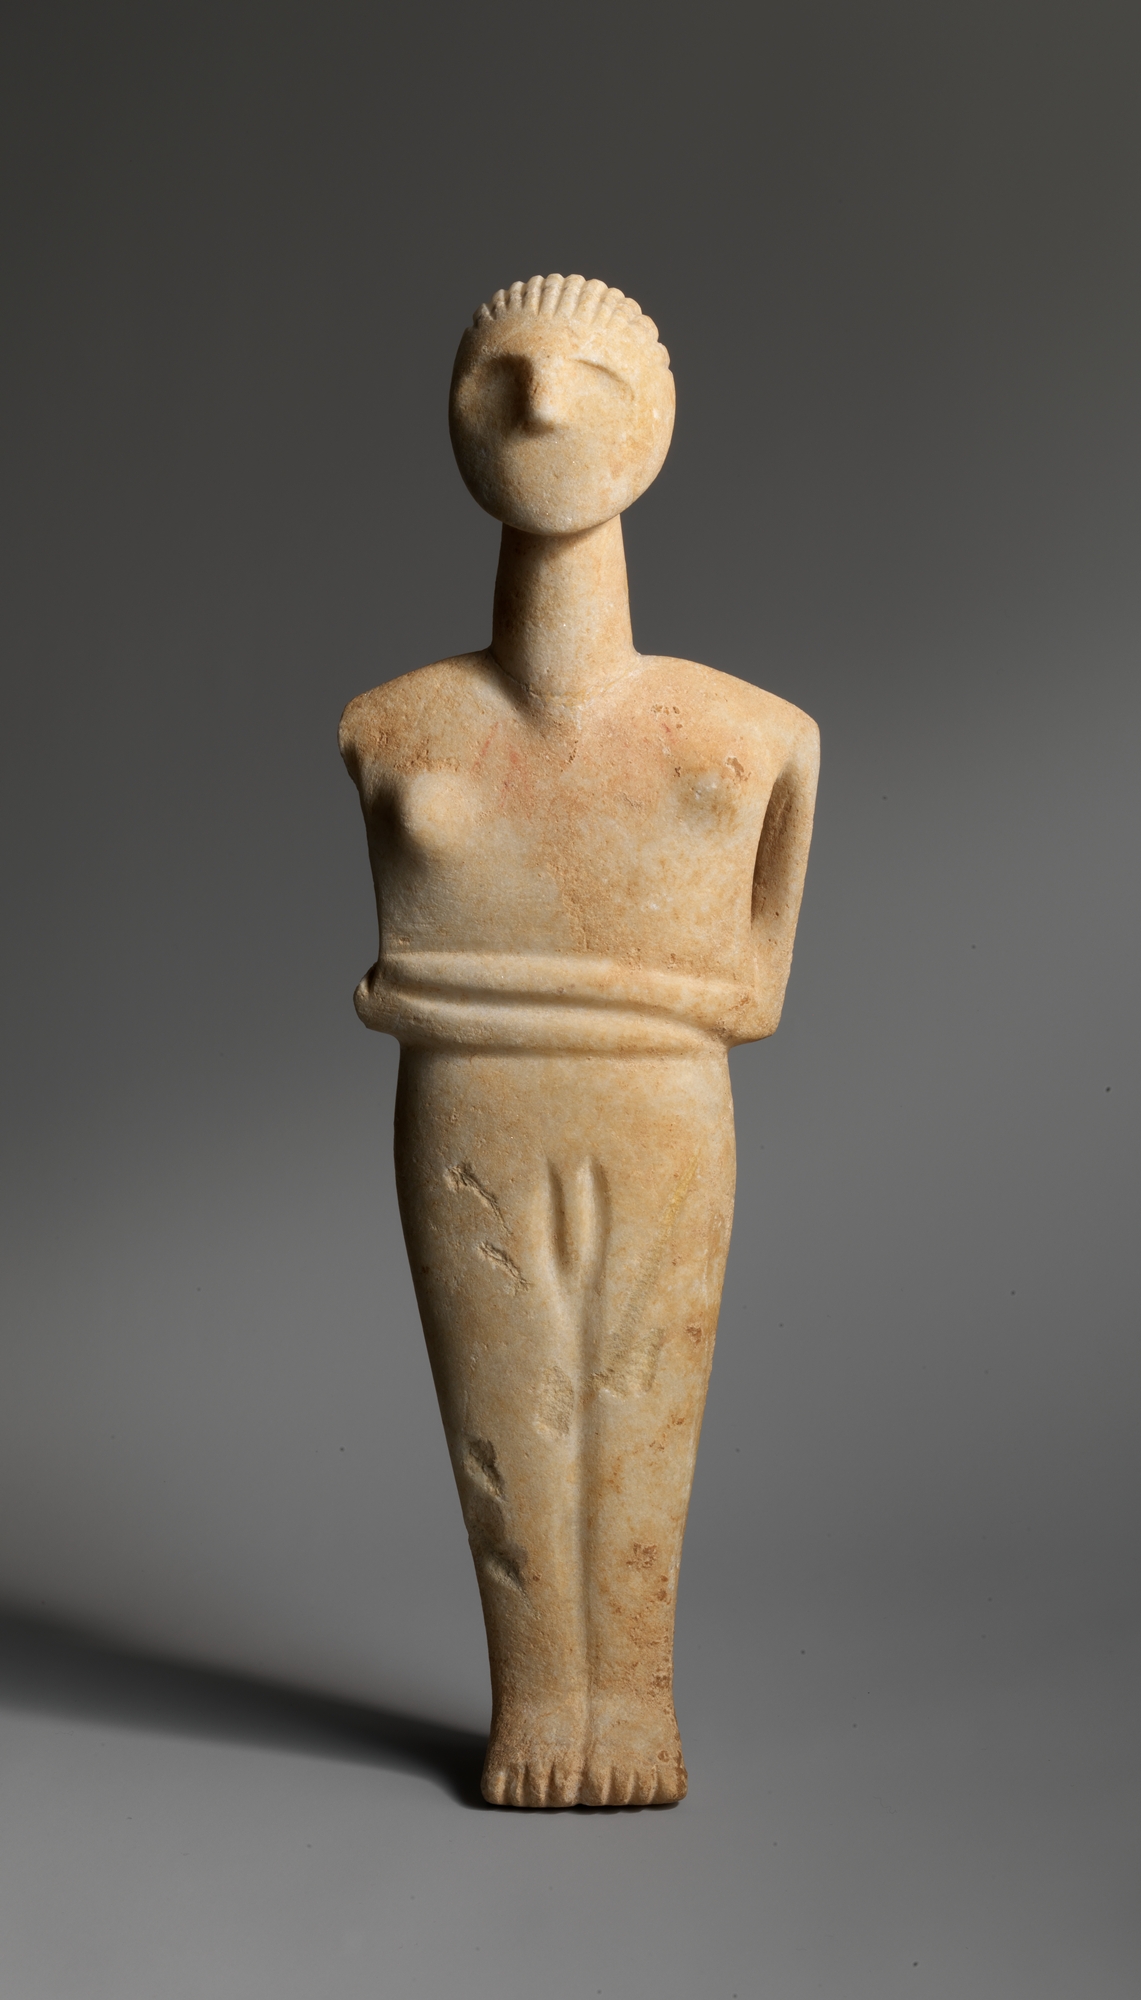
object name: statuette of a man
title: Marble male figure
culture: cycladic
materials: marble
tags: men